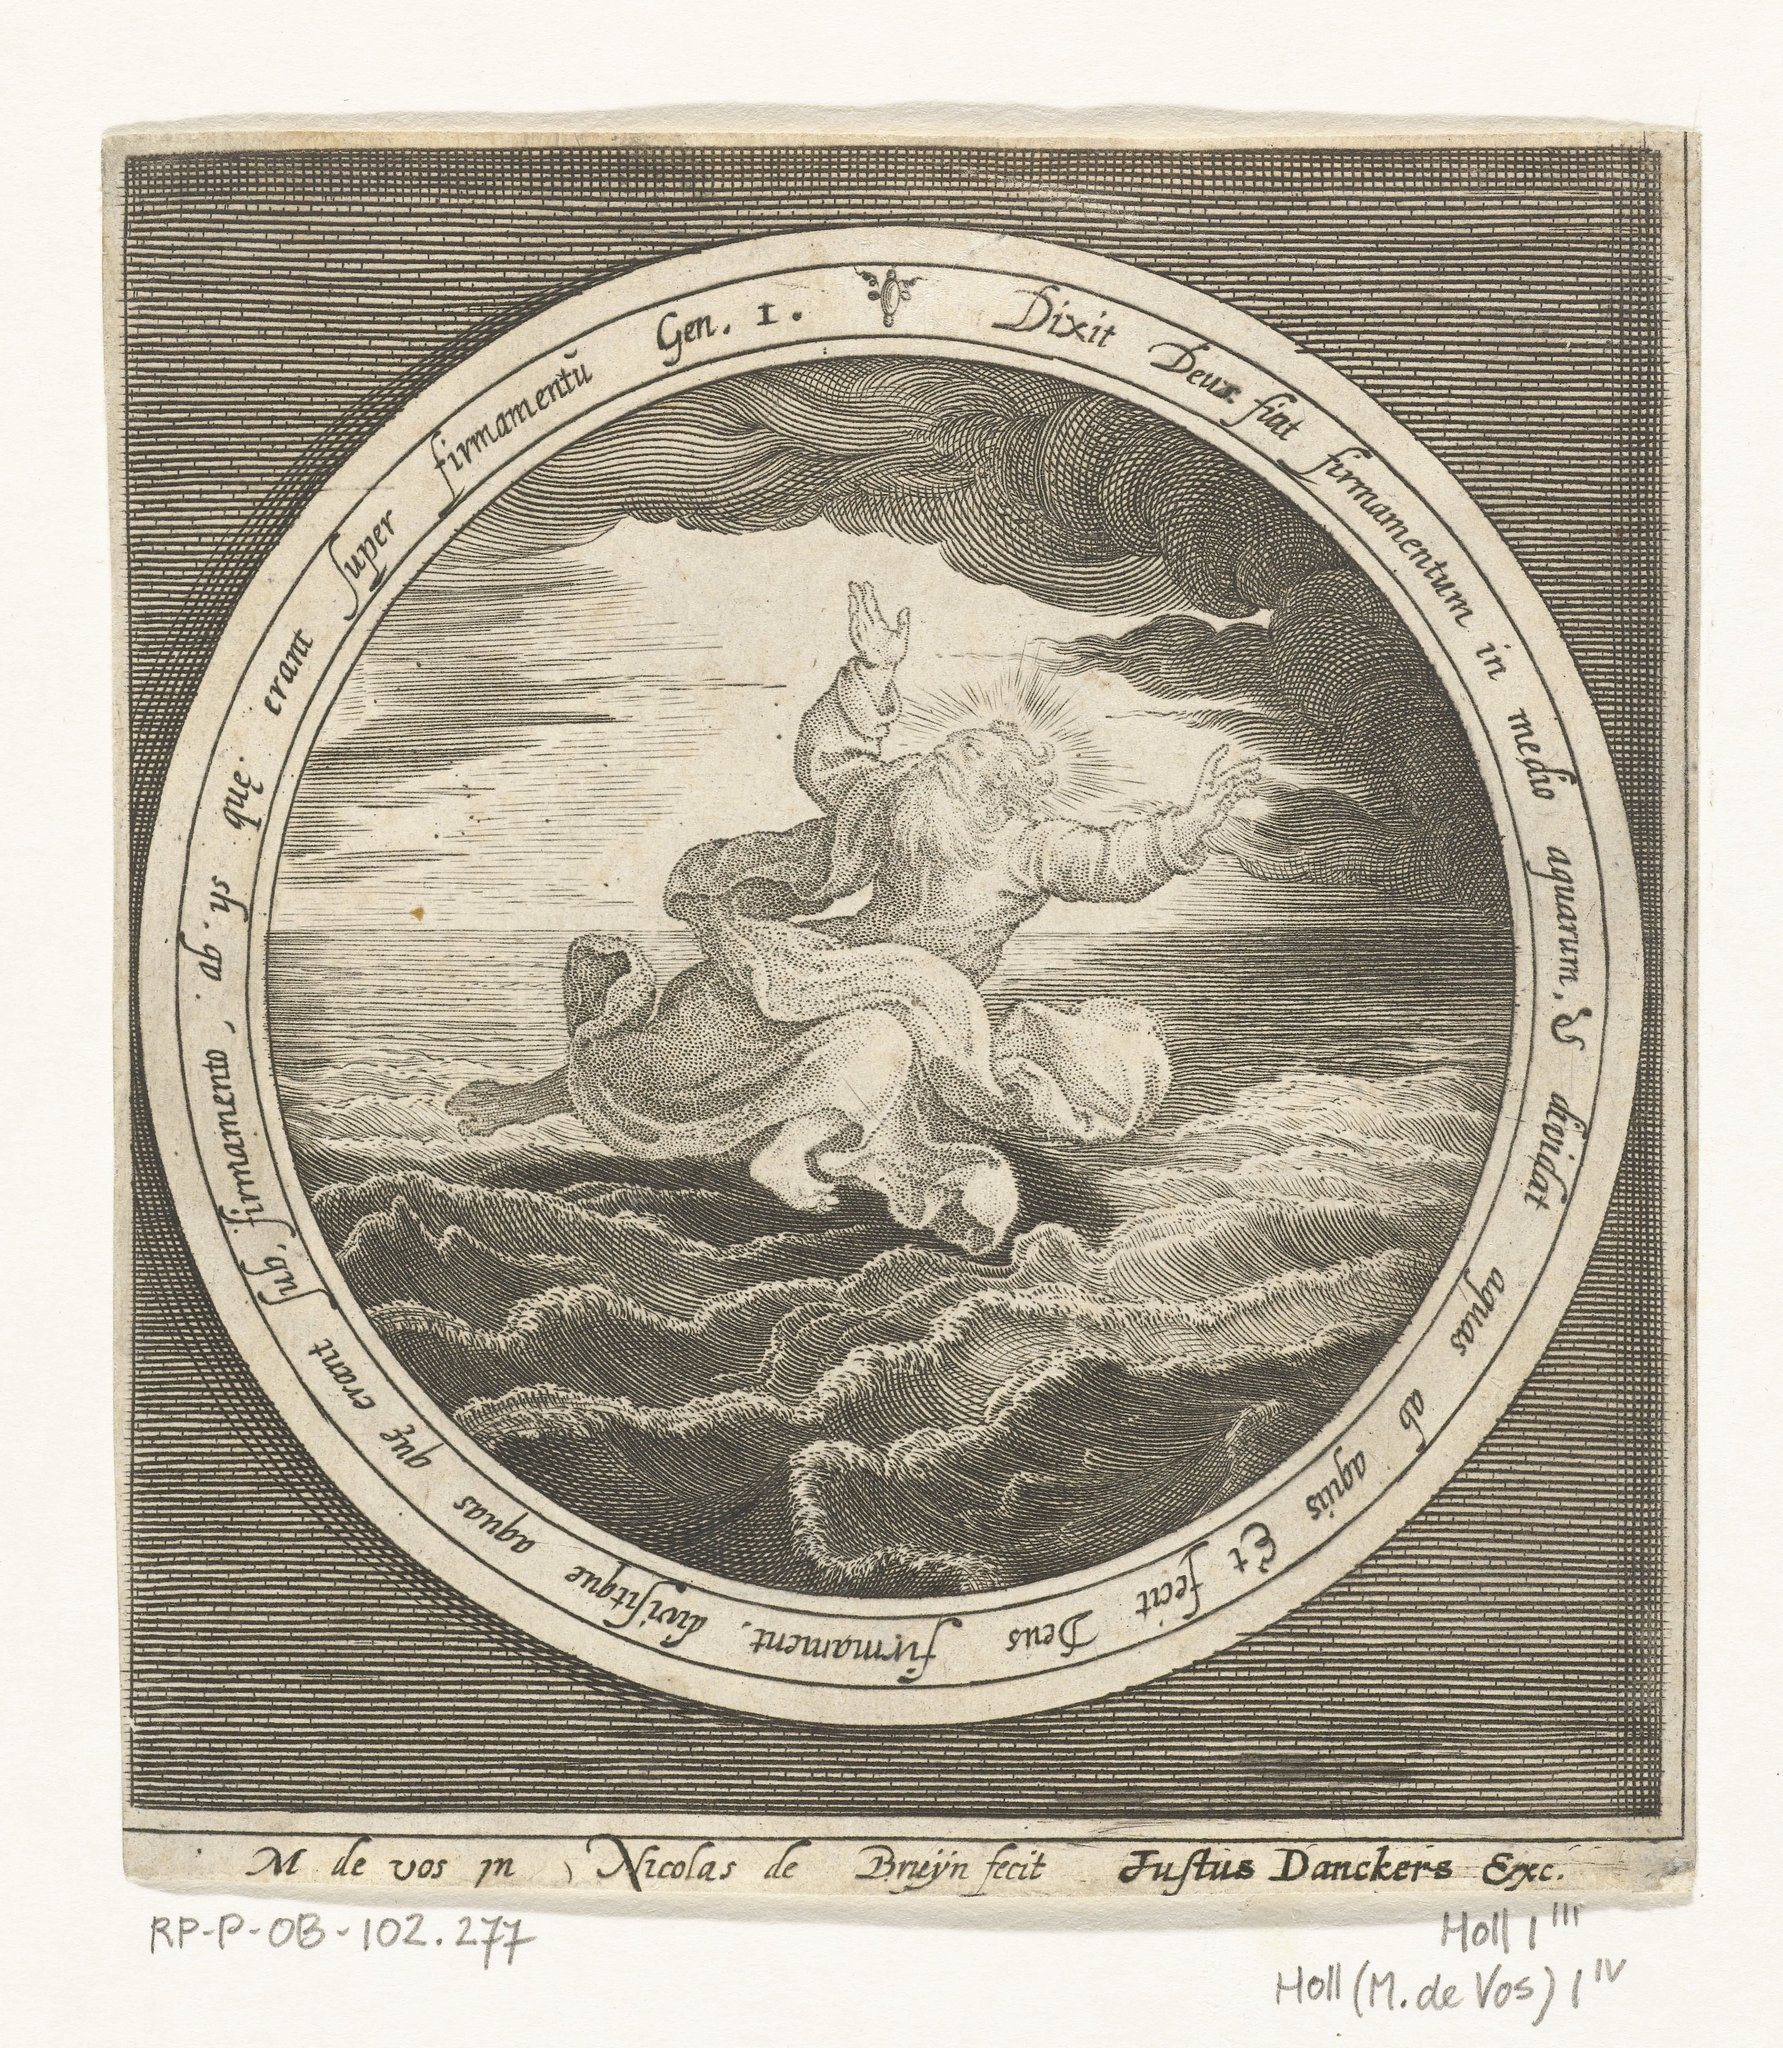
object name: print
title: Tweede dag van schepping: God scheidt de watermassa's in hemel en zee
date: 1581-1656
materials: paper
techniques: engraving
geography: netherlands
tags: creation of the firmament and division of the waters above and below it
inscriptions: collector's mark: Lugt 2228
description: Tweede dag van schepping: God scheidt de watermassa's in hemel en zee. In medaillon met als opschrift een bijbeltekst in Latijn uit Genesis 1 binnen vierkante omlijsting.